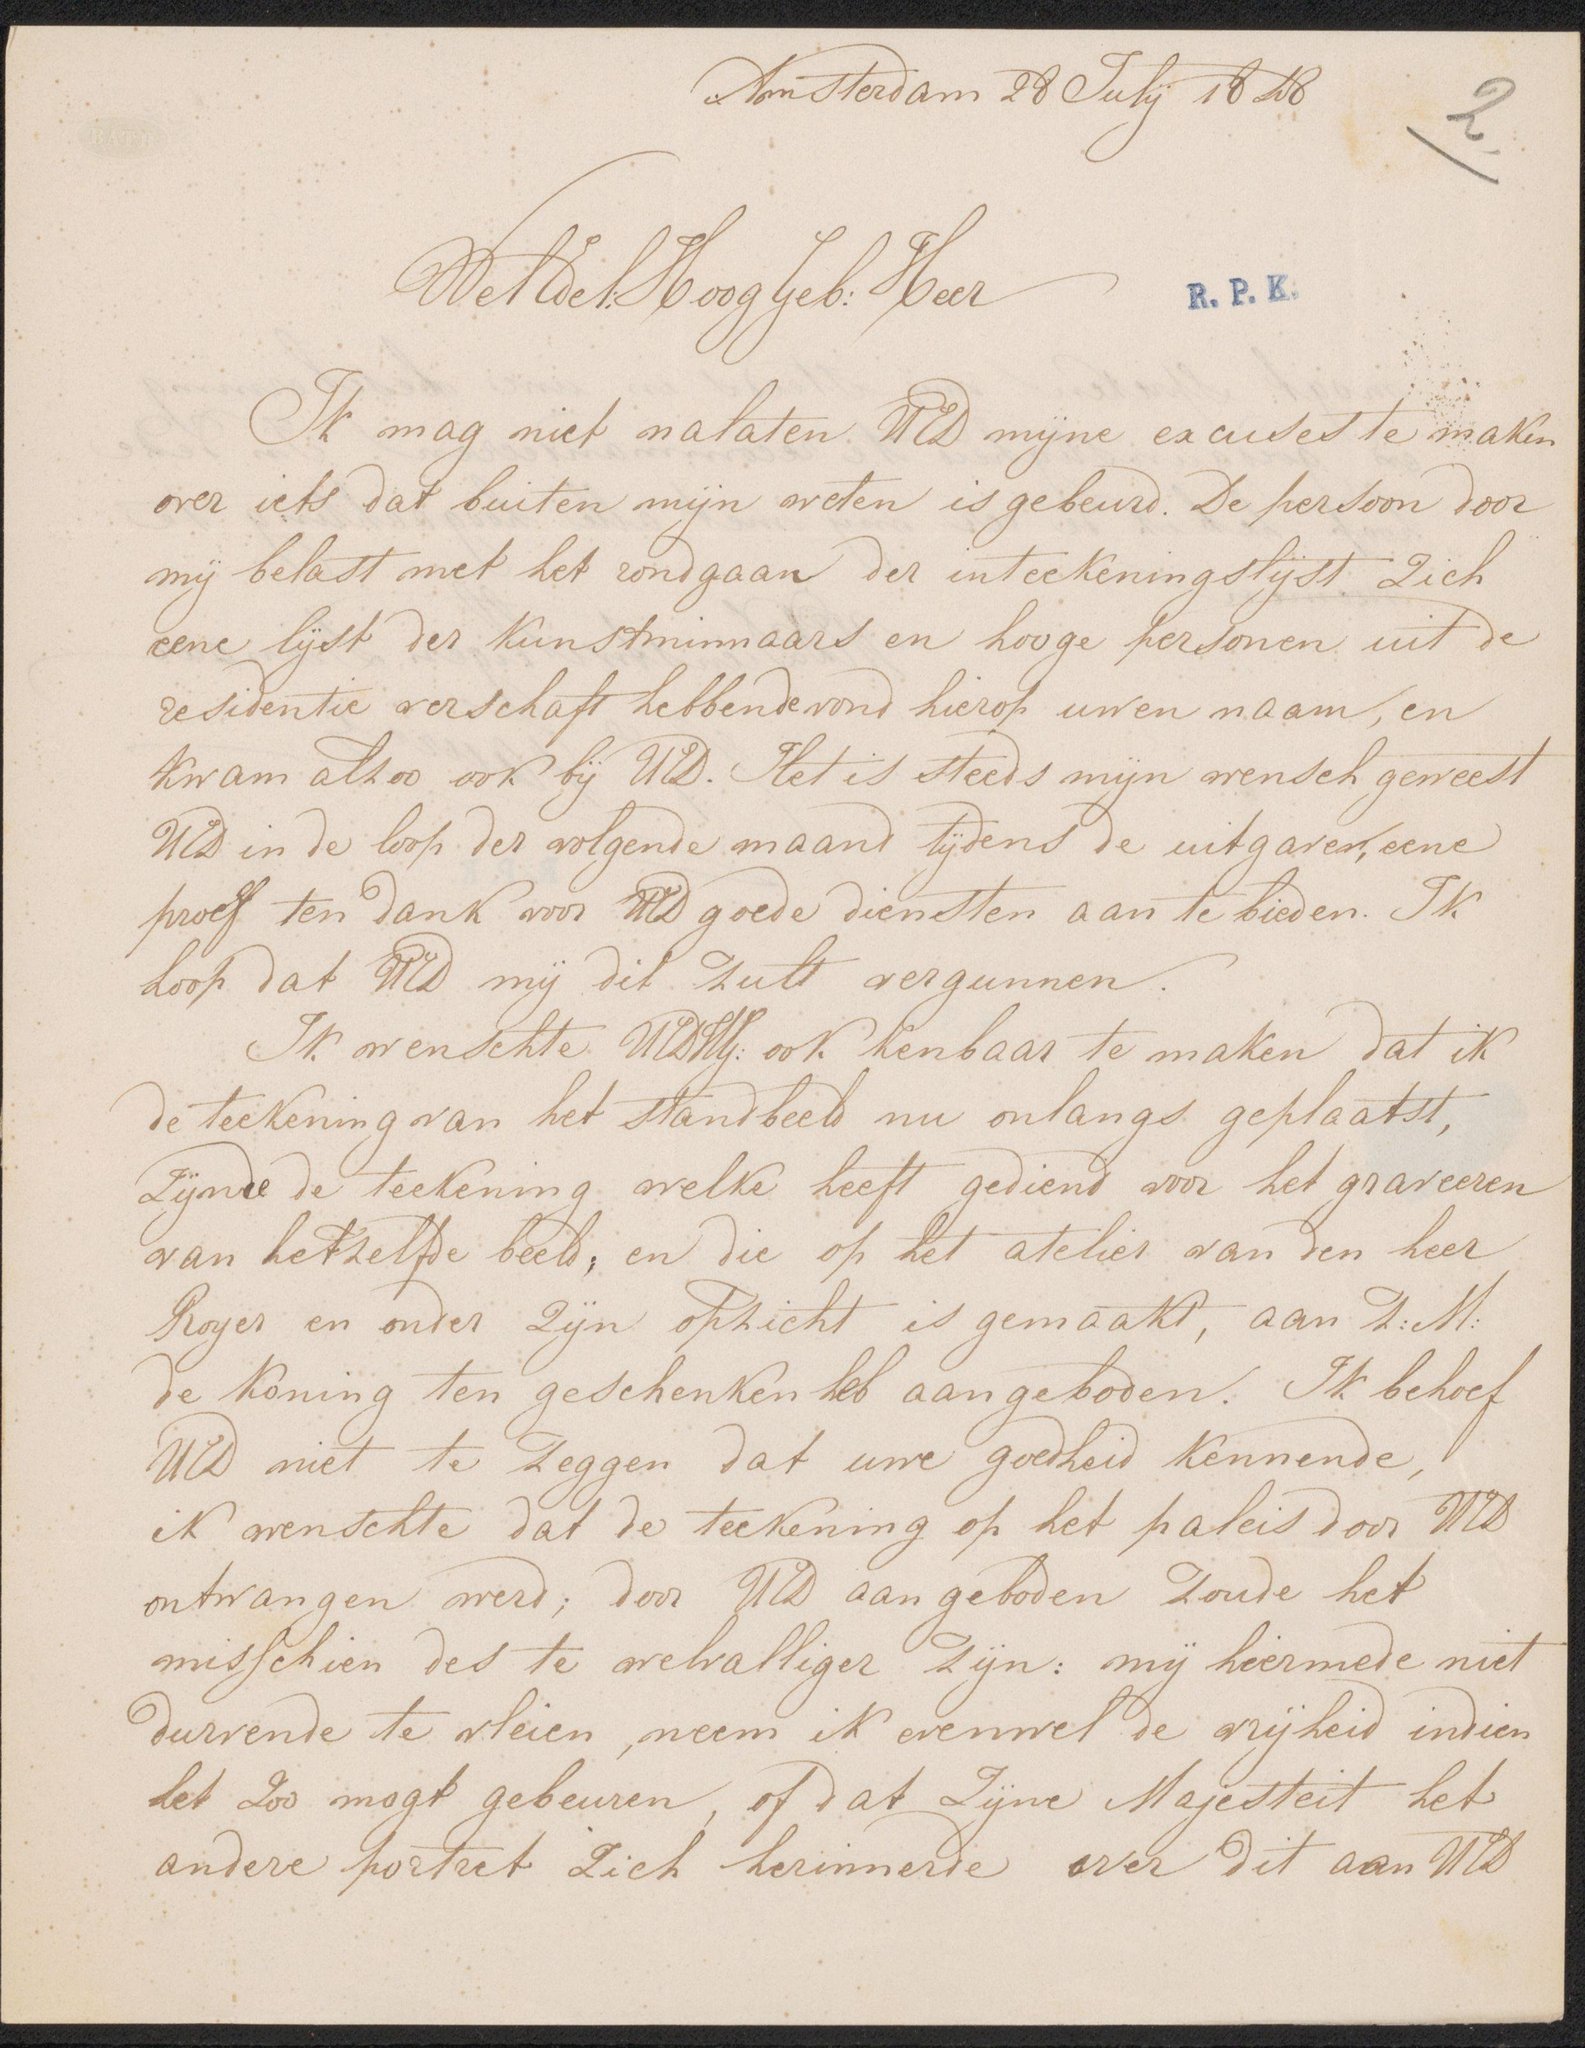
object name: letter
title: Brief aan jonkheer Johannes Gerrit Willem Merkes van Gendt, adjudant van Willem II (Koning der Nederlanden)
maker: edouard taurel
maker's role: draughtsman, print maker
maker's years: 1824-1892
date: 1848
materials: ink, paper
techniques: pen, writing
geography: amsterdam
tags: sculptor, louis royer, the hague, william ii of the netherlands, drawing, the graphic arts, sculpture, workshop, studio of the artist (in general)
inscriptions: collector's mark: Lugt 2233